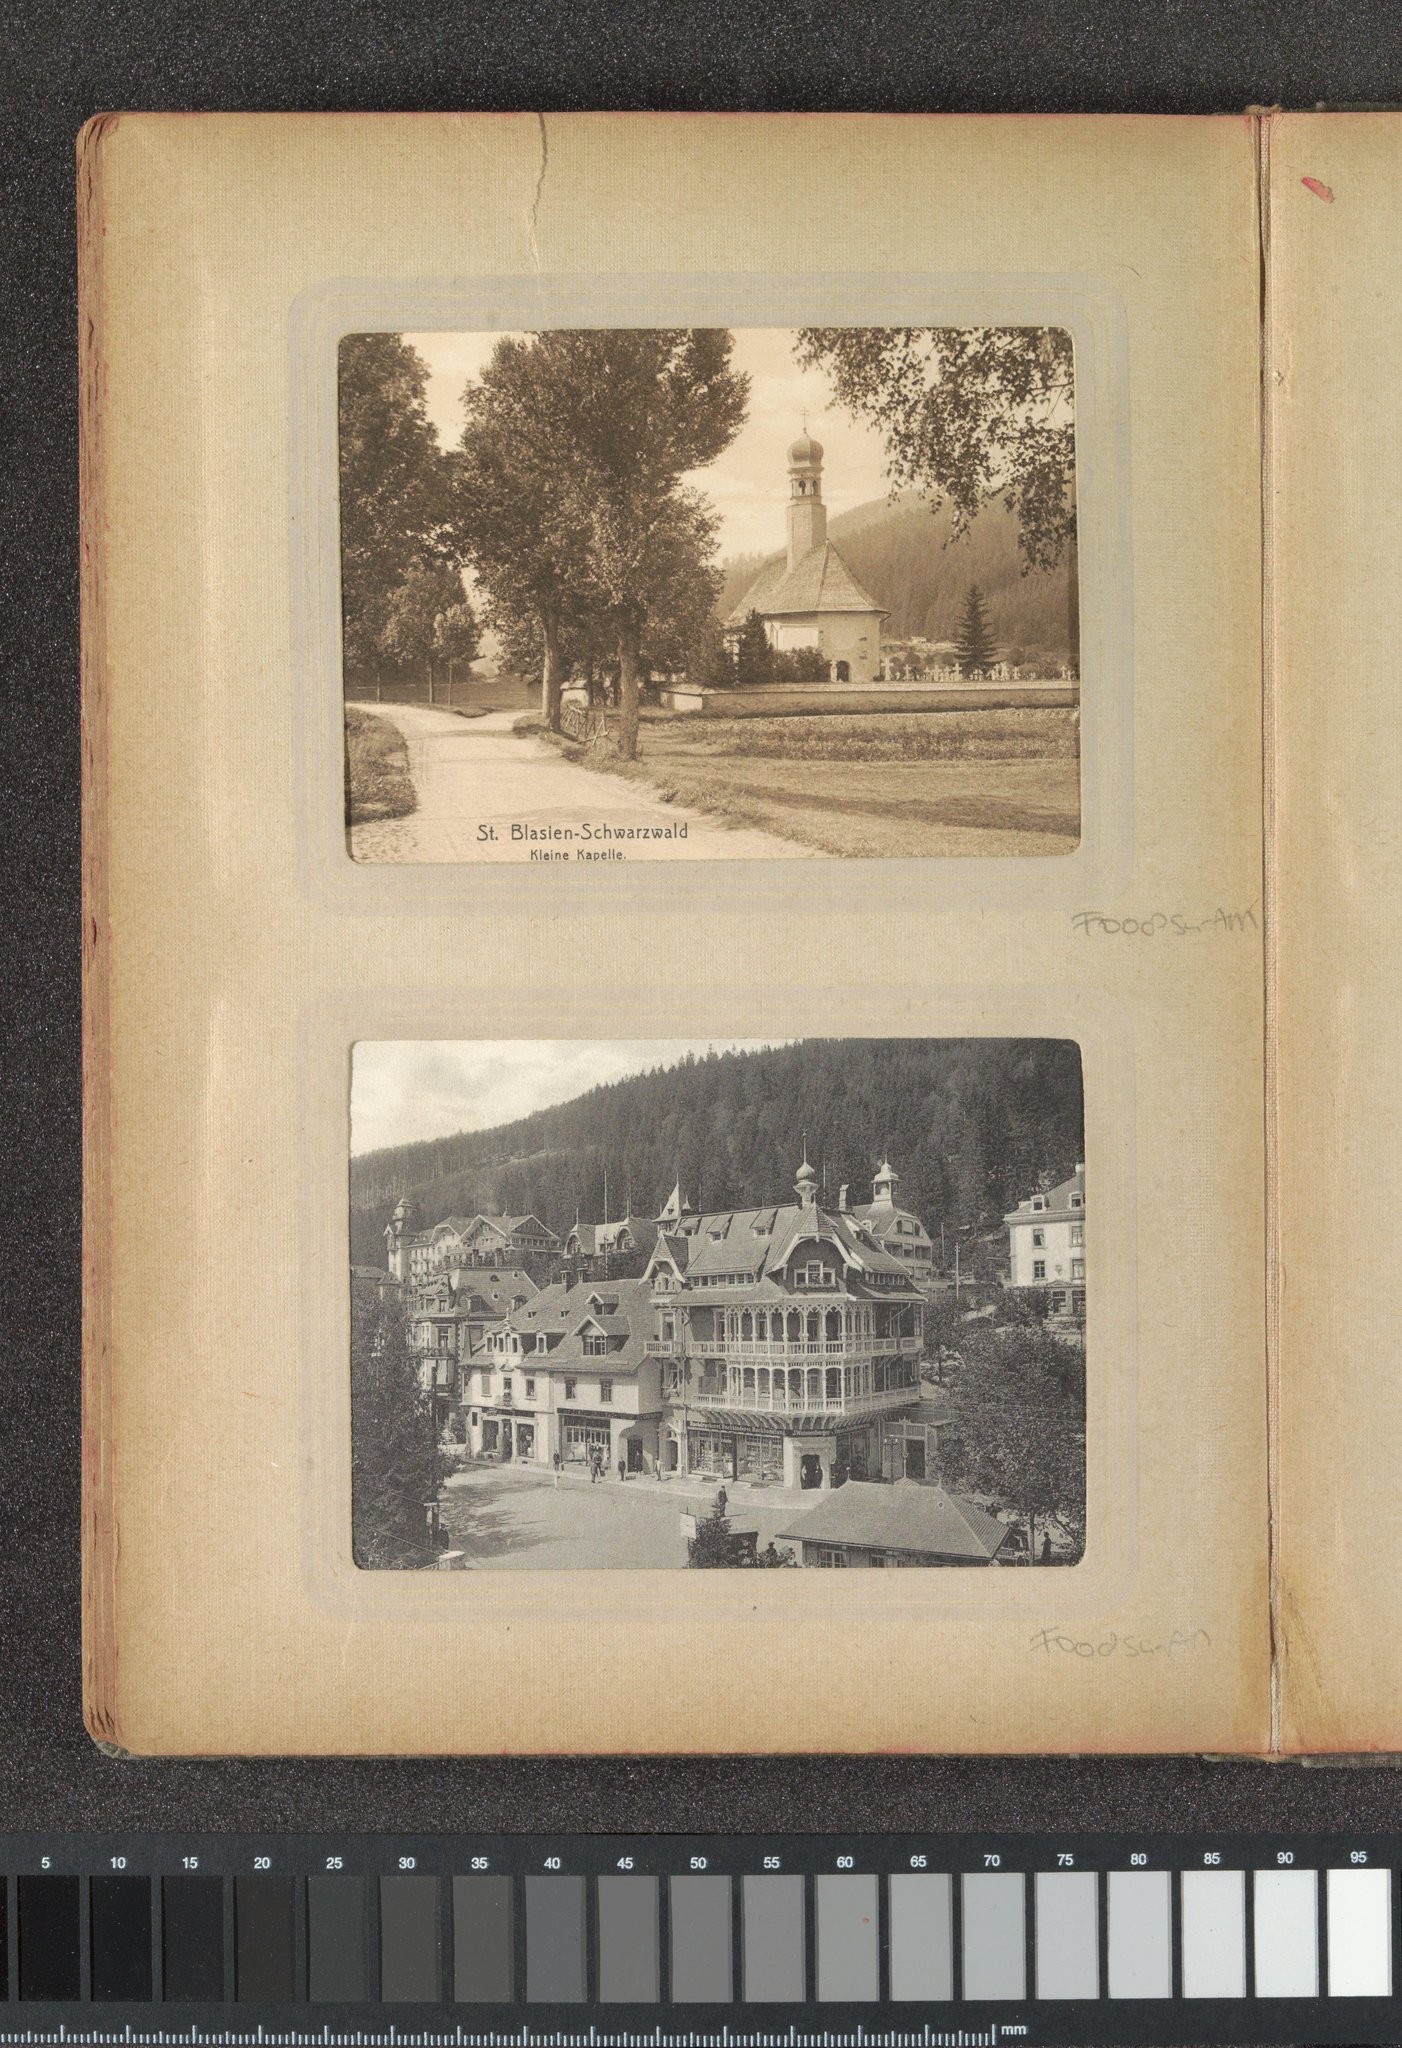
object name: ansichtkaart, prentbriefkaart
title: Sint-Michaëlkapel en landweg in St. Blasien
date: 1890-1910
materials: cardboard, paper, photographic support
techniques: photograph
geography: st. blasien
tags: road, path, church (exterior) - qq - small church, chapel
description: Onderdeel van Fotoalbum van Carl Heinrich Fliegenschmidt, gevangenisdirecteur te Oslebshausen.